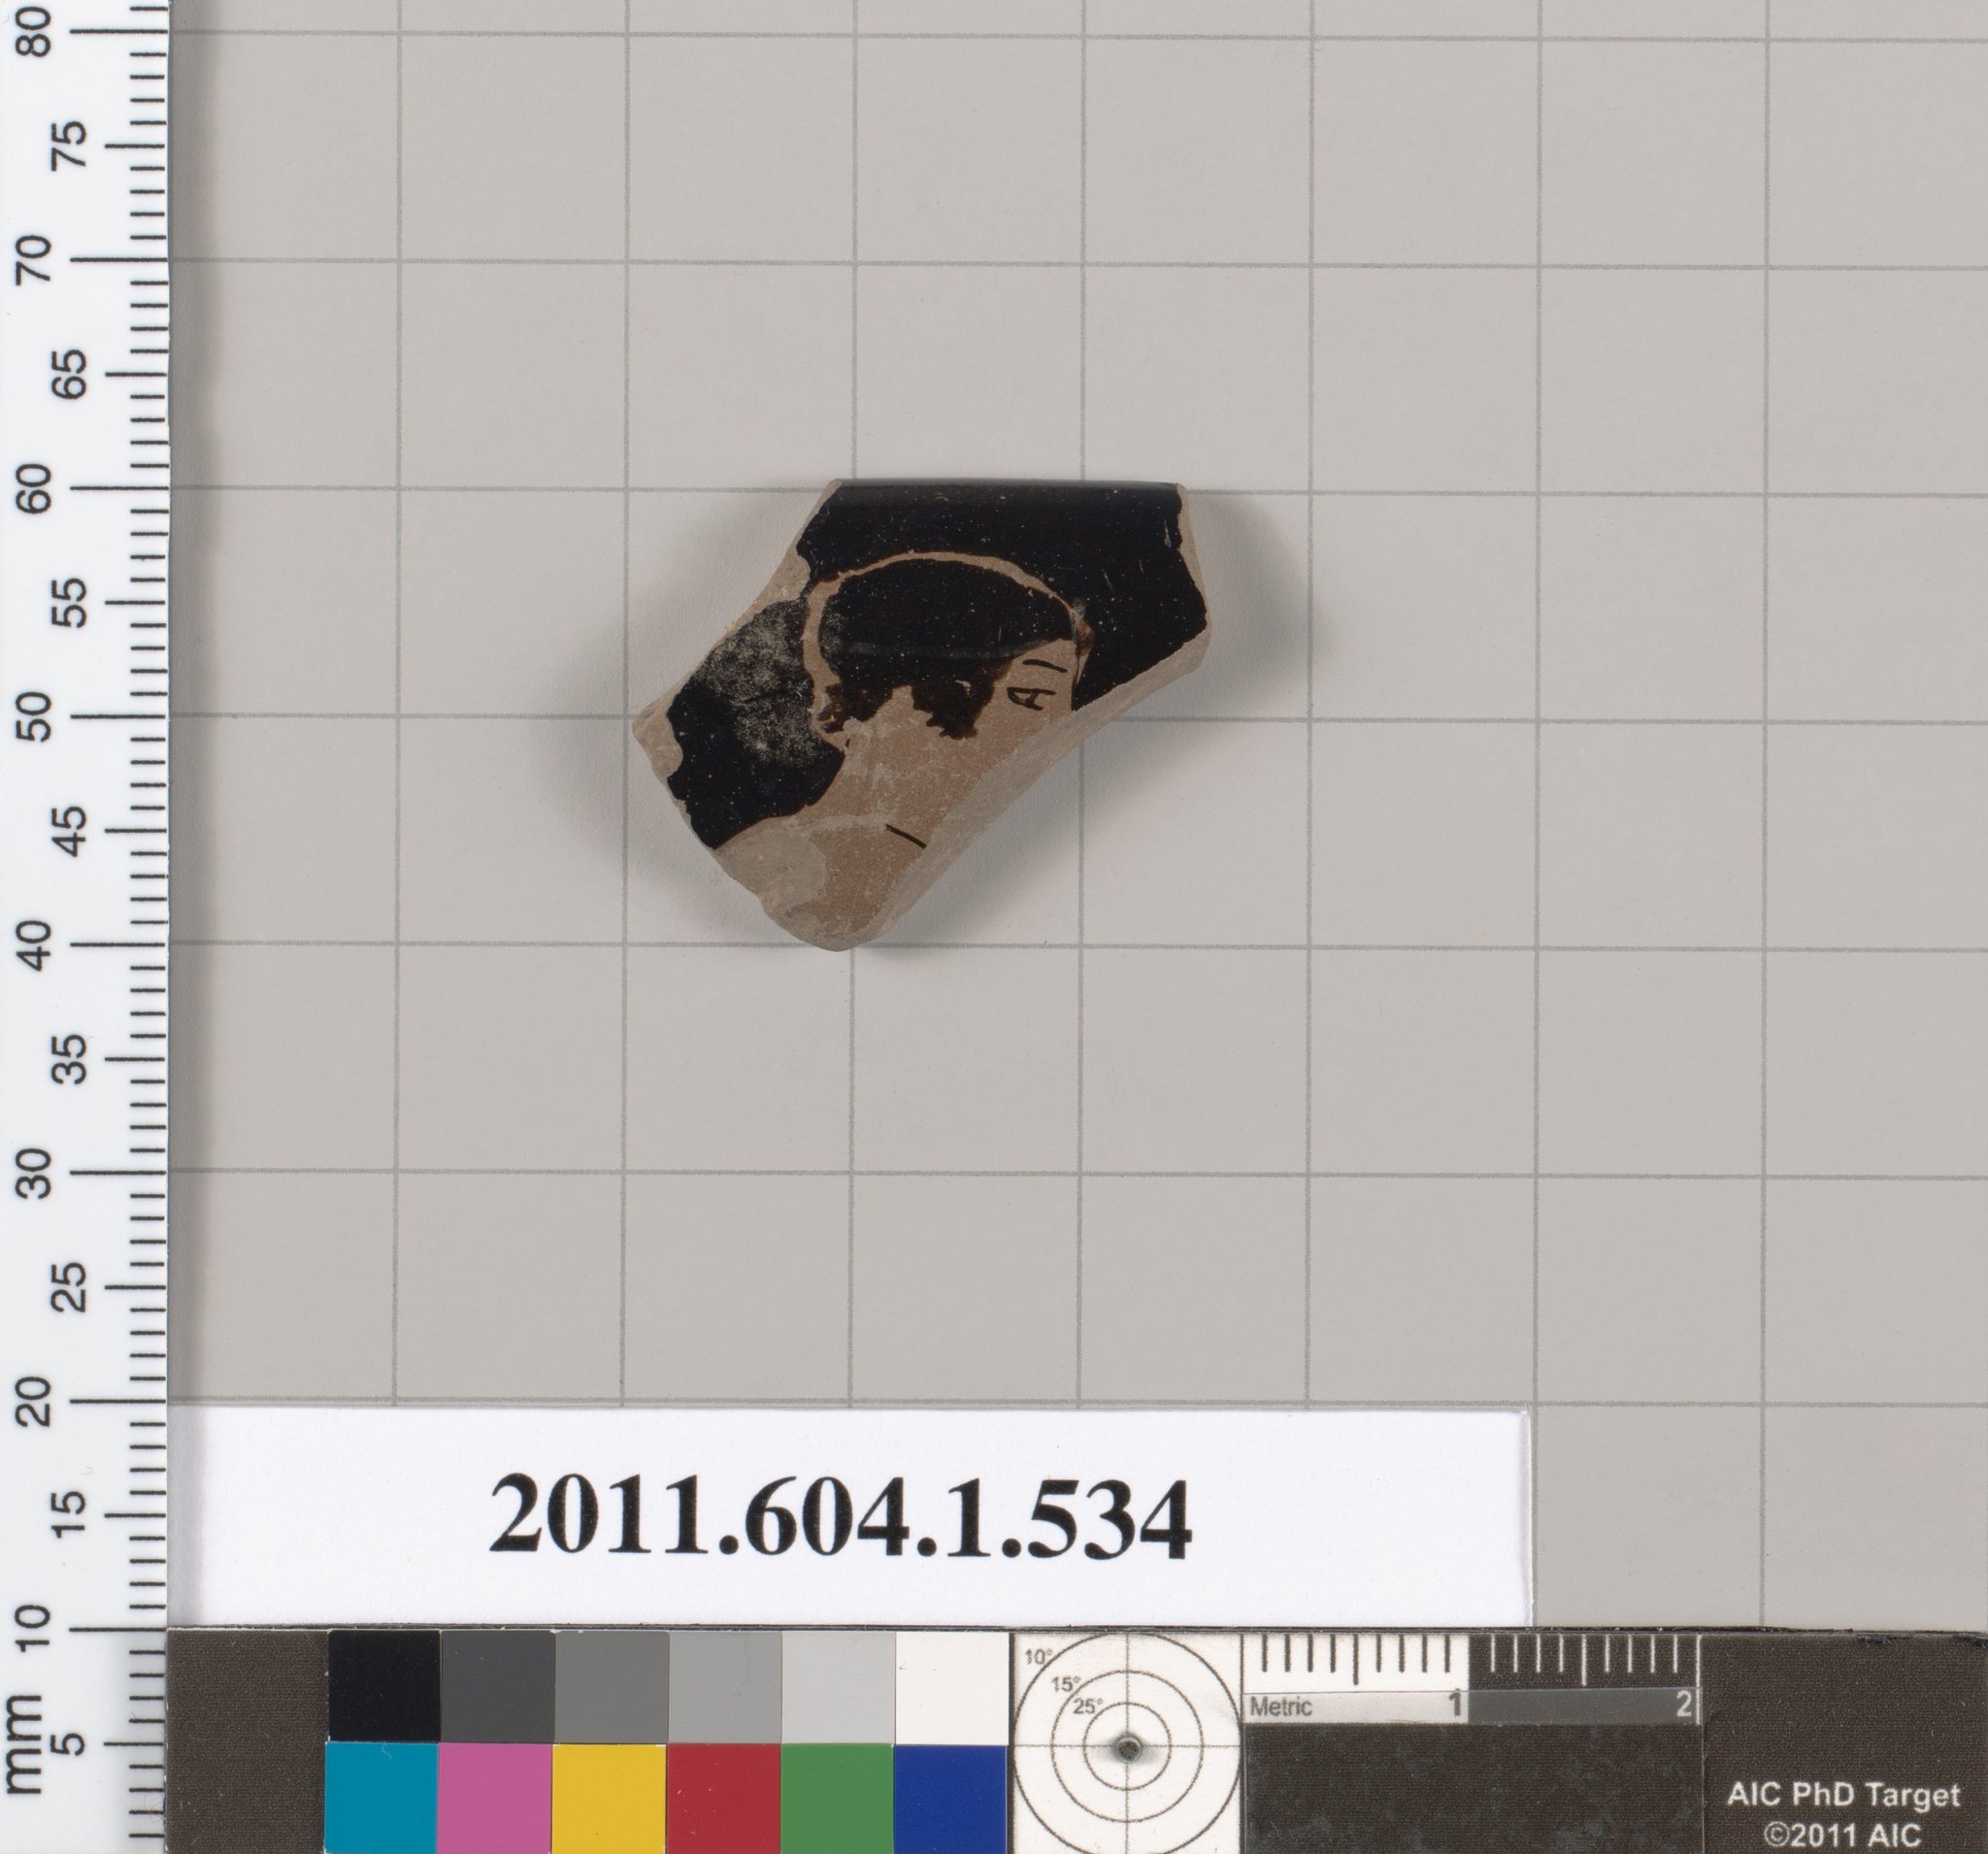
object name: kylix fragment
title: Terracotta rim fragment of a kylix (drinking cup)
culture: greek, attic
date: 480-470 BCE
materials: terracotta